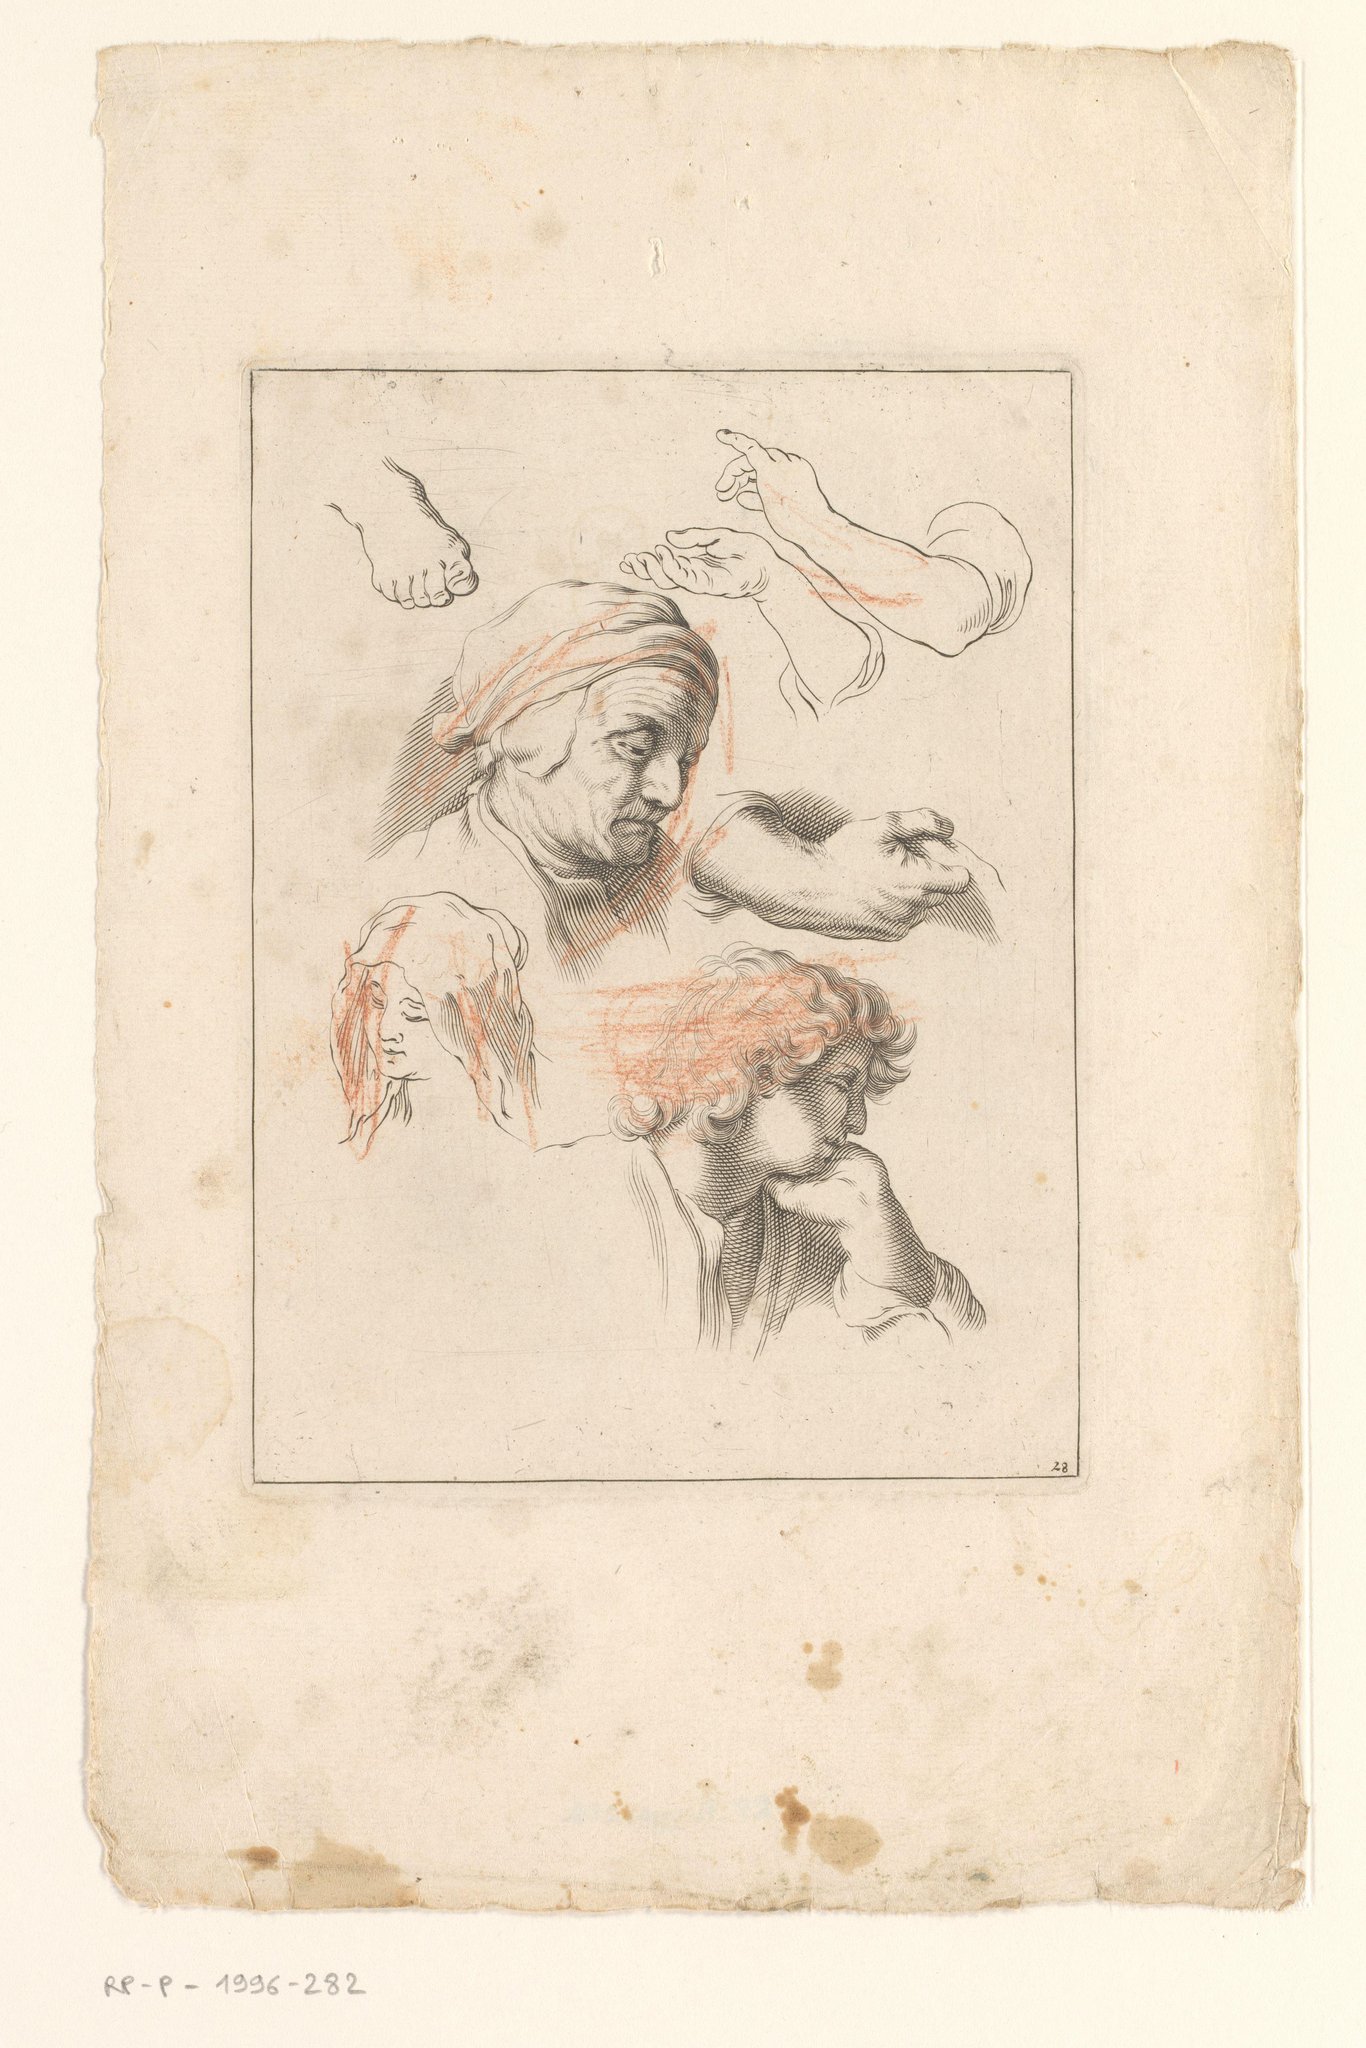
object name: print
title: Drie hoofden, drie armen en een voet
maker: Anonymous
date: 1650-1750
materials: paper, pencil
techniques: engraving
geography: northern netherlands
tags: head (human), postures and gestures of arms and hands in general, foot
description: Studieblad met kop van een jongeman, van een jonge vrouw en een oude vrouw met muts op. Studie van een voet en armen. Uit 'Oorspronkelyk en vermaard Konstryk Tekenboek' van Abraham Bloemaert: Genummerd 28 (Met bruin potlood overheen gekrast, door een kind).